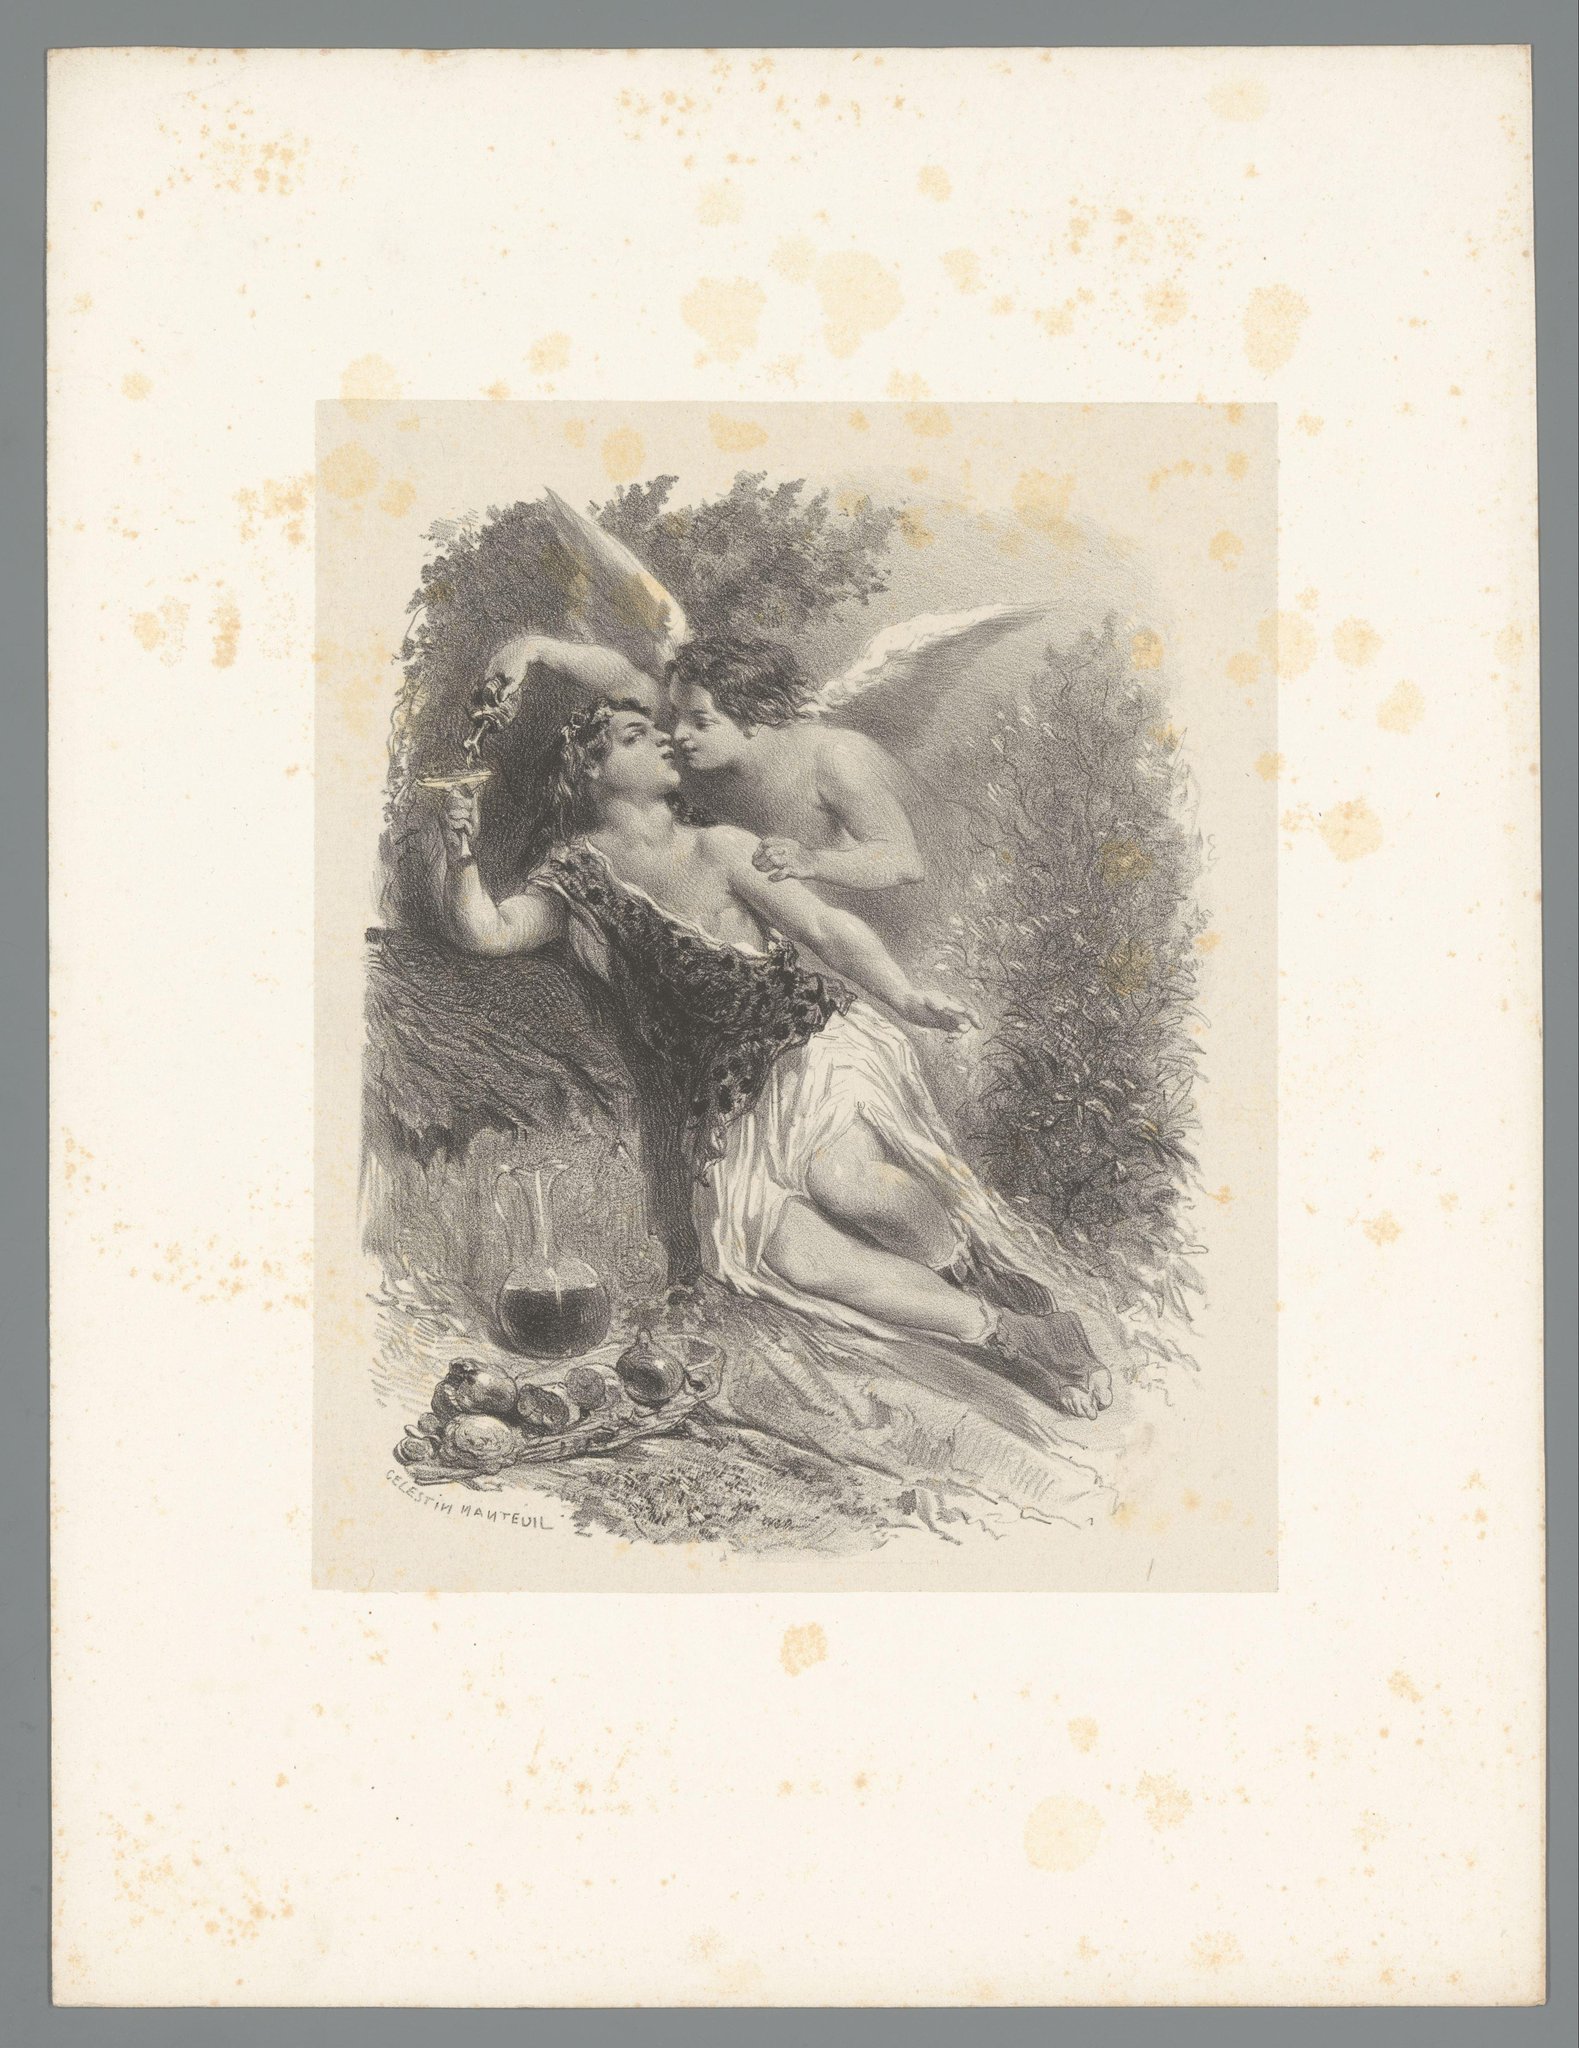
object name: print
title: Man en engel in intieme houding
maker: célestin françois nanteuil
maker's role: print maker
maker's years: 1813-1873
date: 1823-1873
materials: paper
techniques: lithograph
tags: homosexual love, alcoholic drinks, angels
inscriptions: collector's mark: Lugt 964